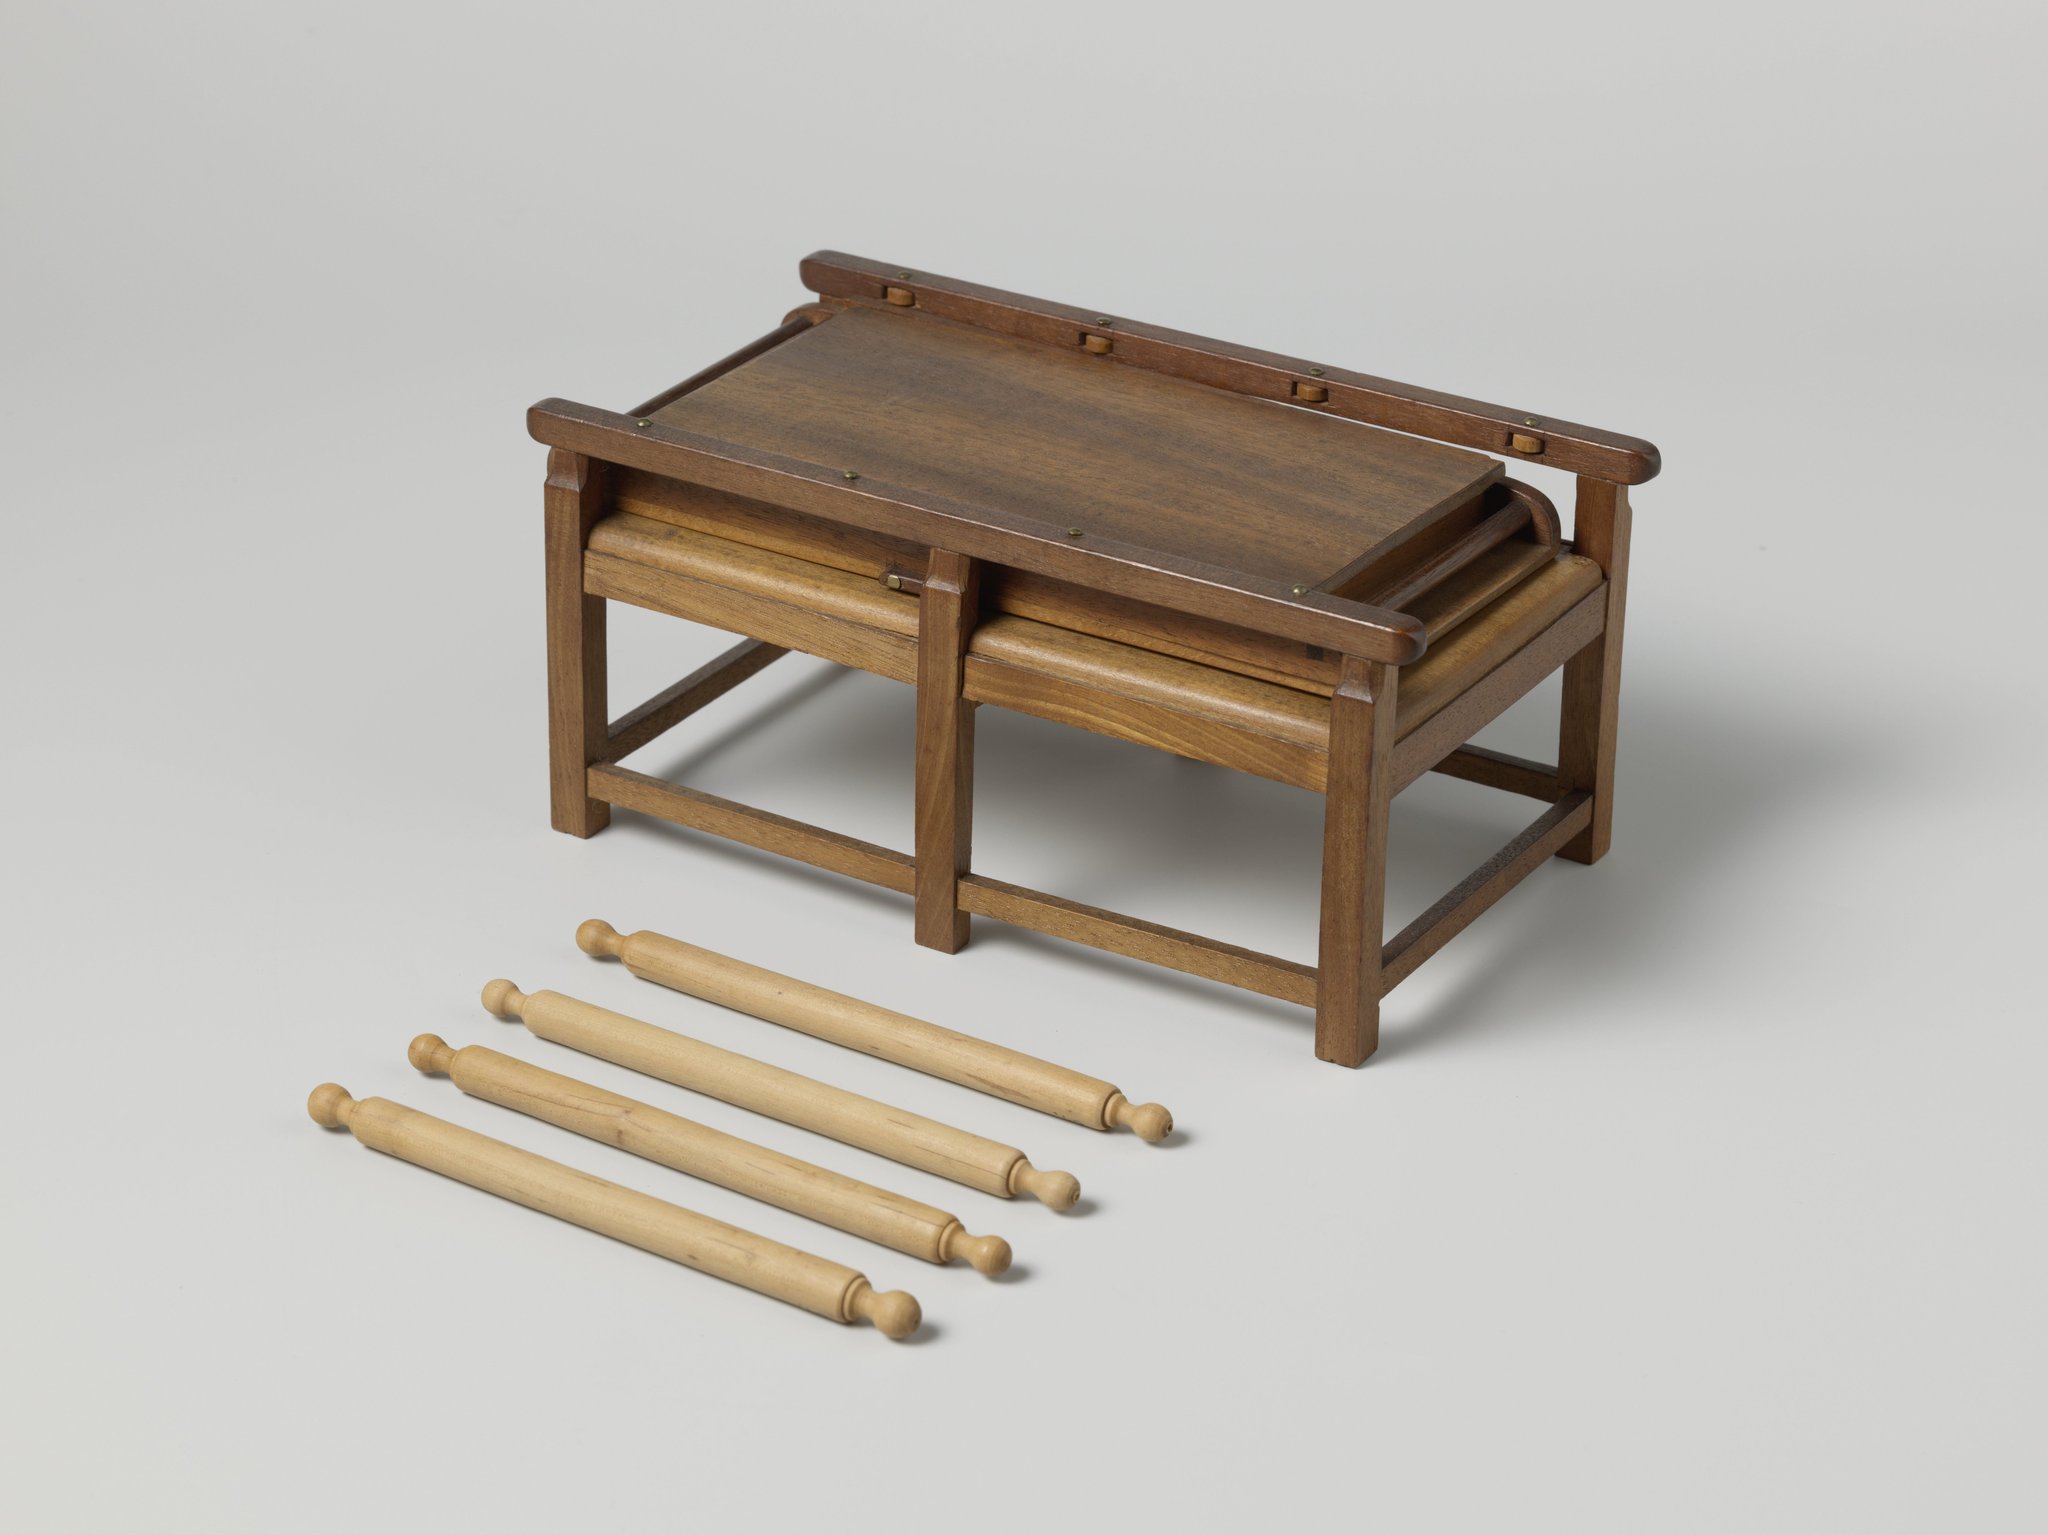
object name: mangeltafel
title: Trekmangel met vier mangelrollers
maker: Anonymous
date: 1750-1800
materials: wood, brass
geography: amsterdam